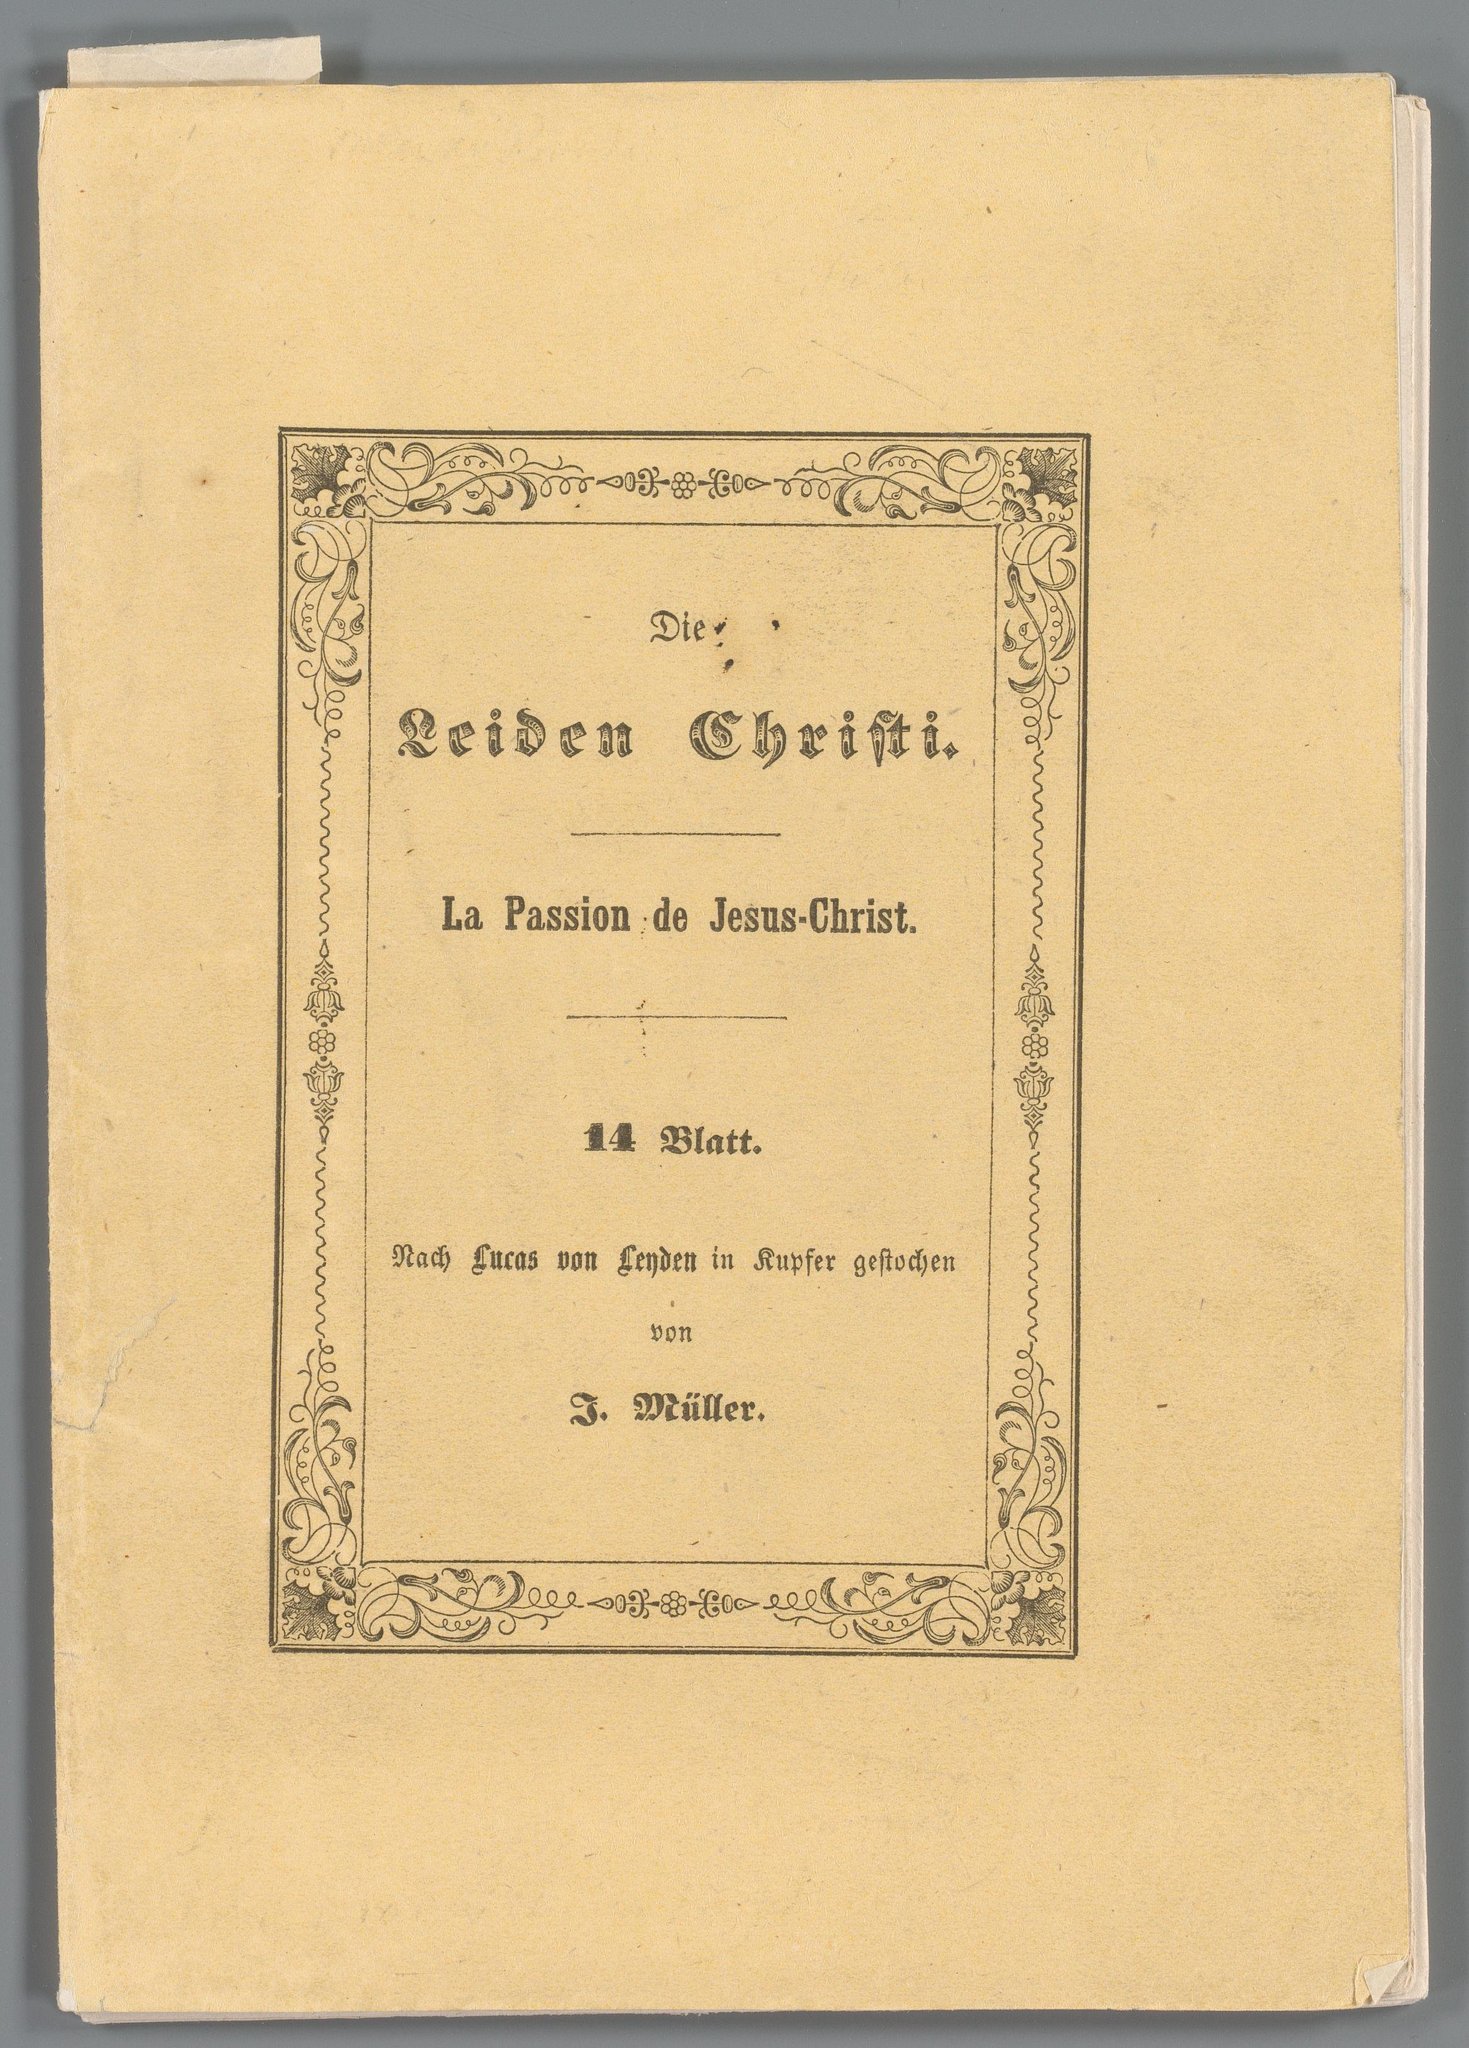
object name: print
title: Passie van Christus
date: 1800-1891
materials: paper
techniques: engraving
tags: letters, alphabet, script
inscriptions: collector's mark: Lugt 2166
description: Dit betreft de omslag van een serie die in de negentiende eeuw is herdrukt met de titel: Die Leiden Christi 14 Blatt. Nach Lucas von Leyden in Kupfer gestochen von J. Müller.